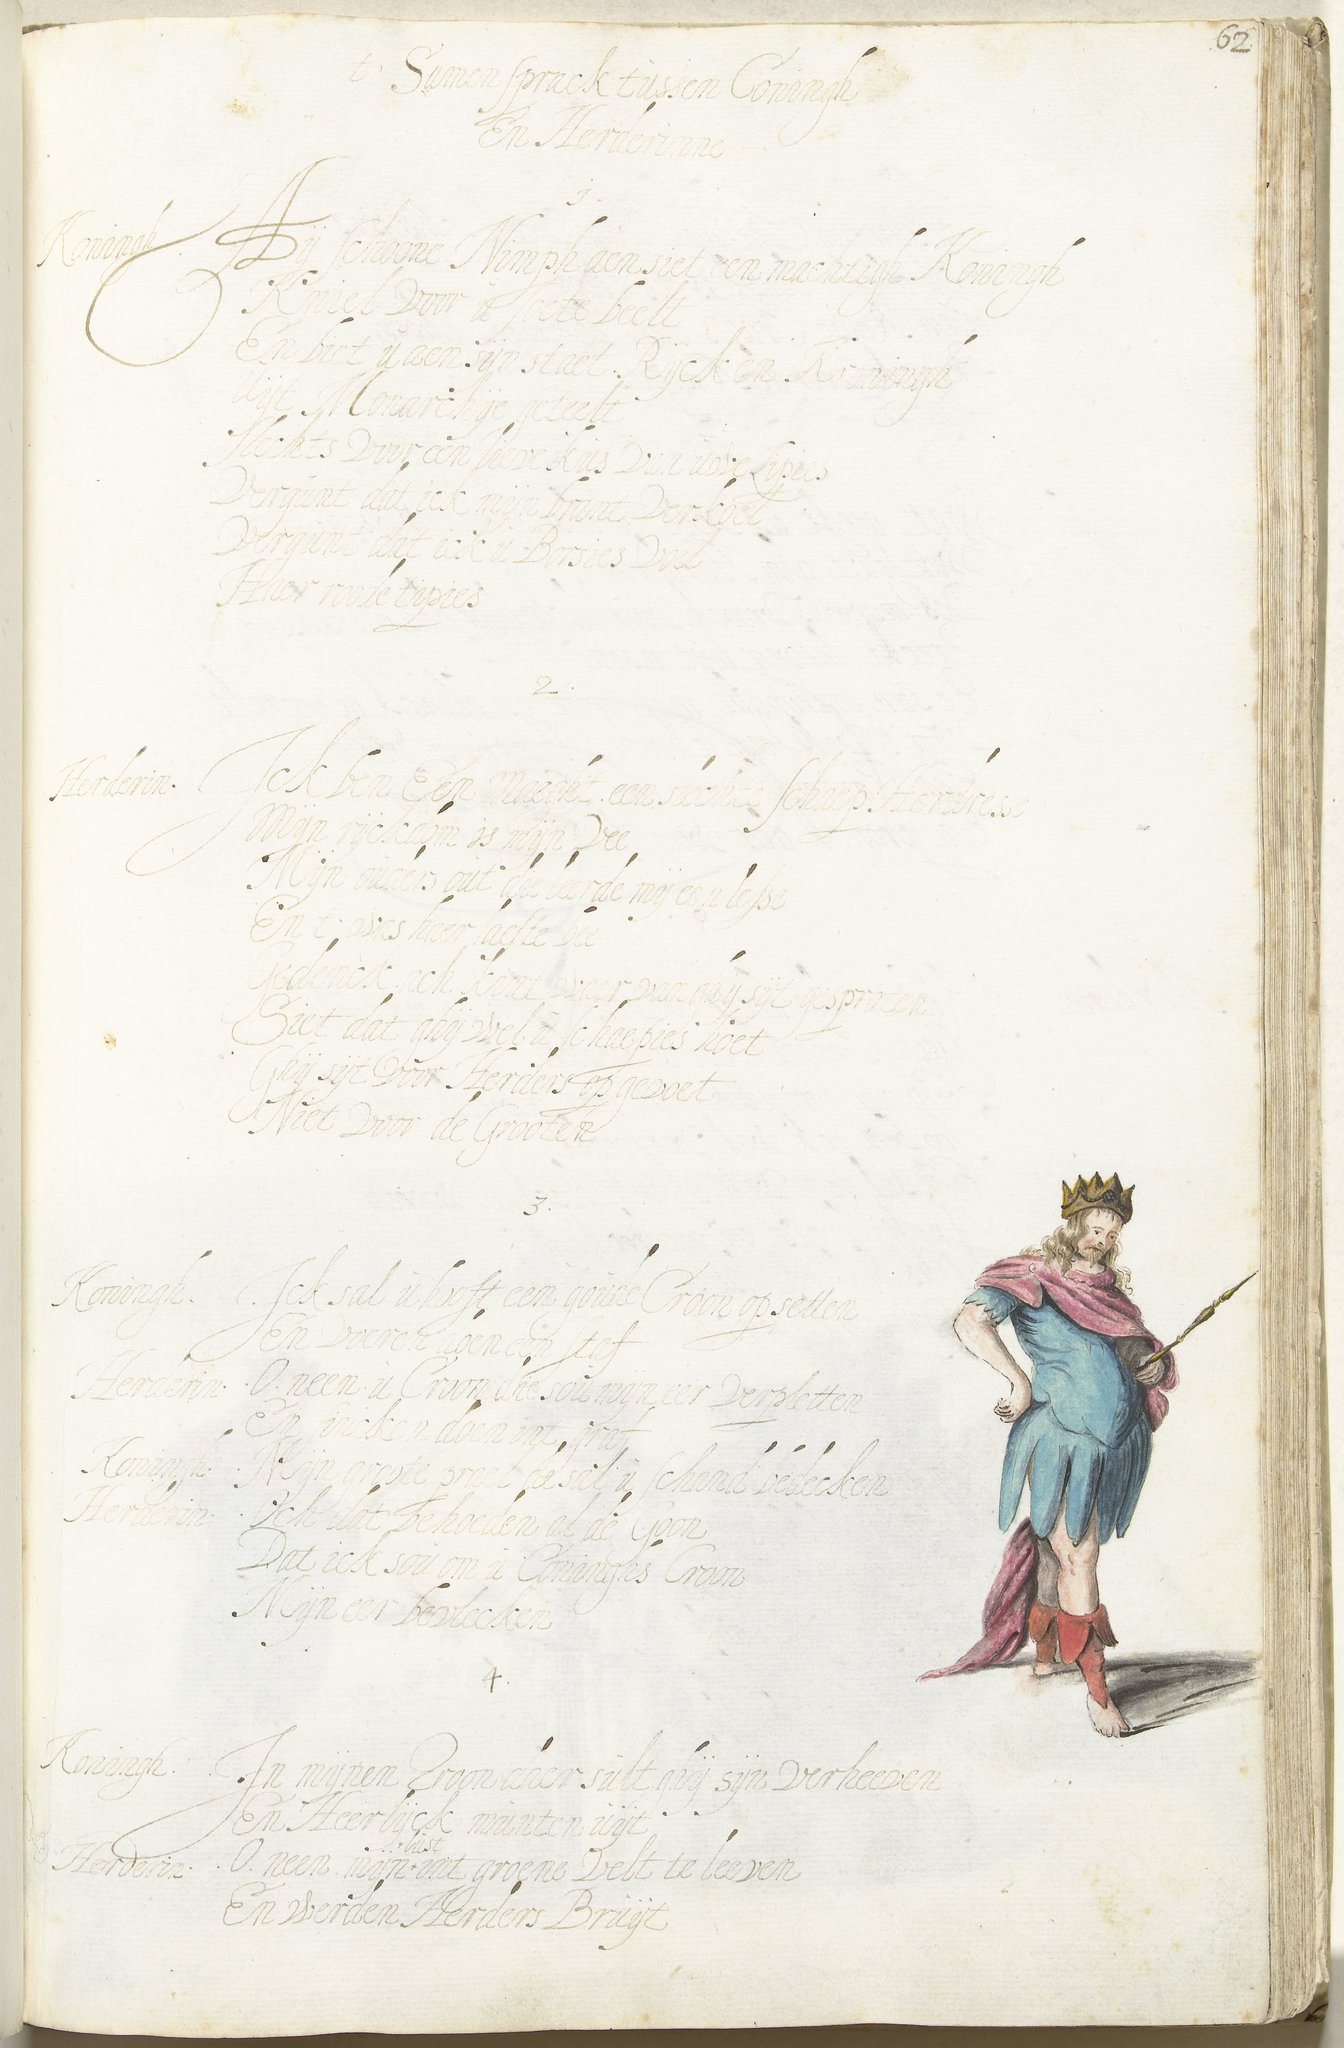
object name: drawing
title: Staande koning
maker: gesina ter borch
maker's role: draughtsman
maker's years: 1633-1690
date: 1654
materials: ink, paper, watercolor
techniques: brush, calligraphy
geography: zwolle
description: Het gedicht is te vinden in de Haerlemsche Laurier-Krans uit 1643 (p. 42) en in het Utrechts Zang-Prieeltien uit 1649 (I, p. 17-20).